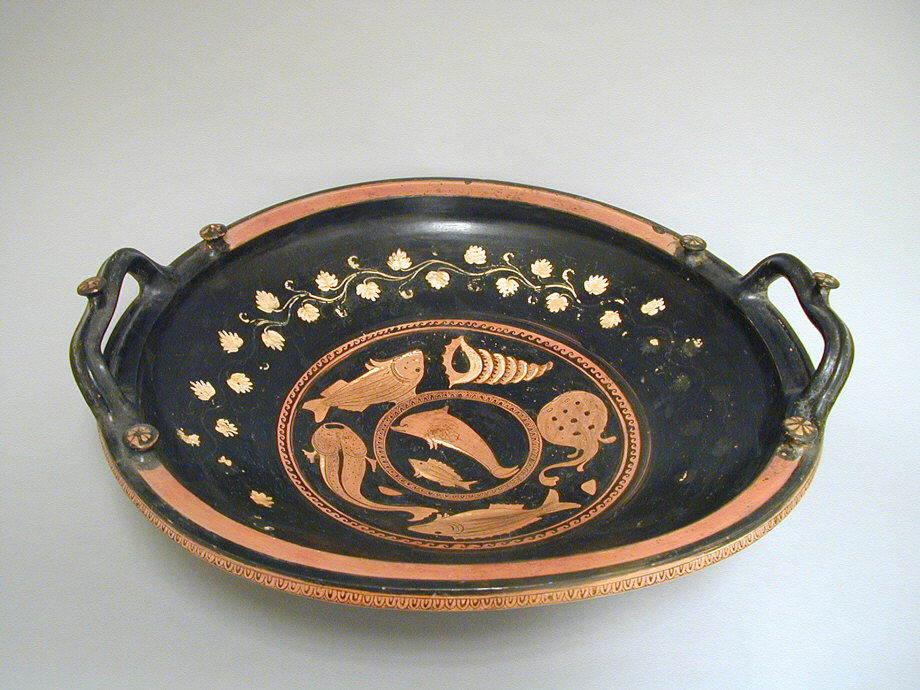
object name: lekanis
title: Terracotta lekanis (dish)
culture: greek, south italian, apulian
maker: phrixos group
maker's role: artist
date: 340-330 BCE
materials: terracotta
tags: dolphins,fish